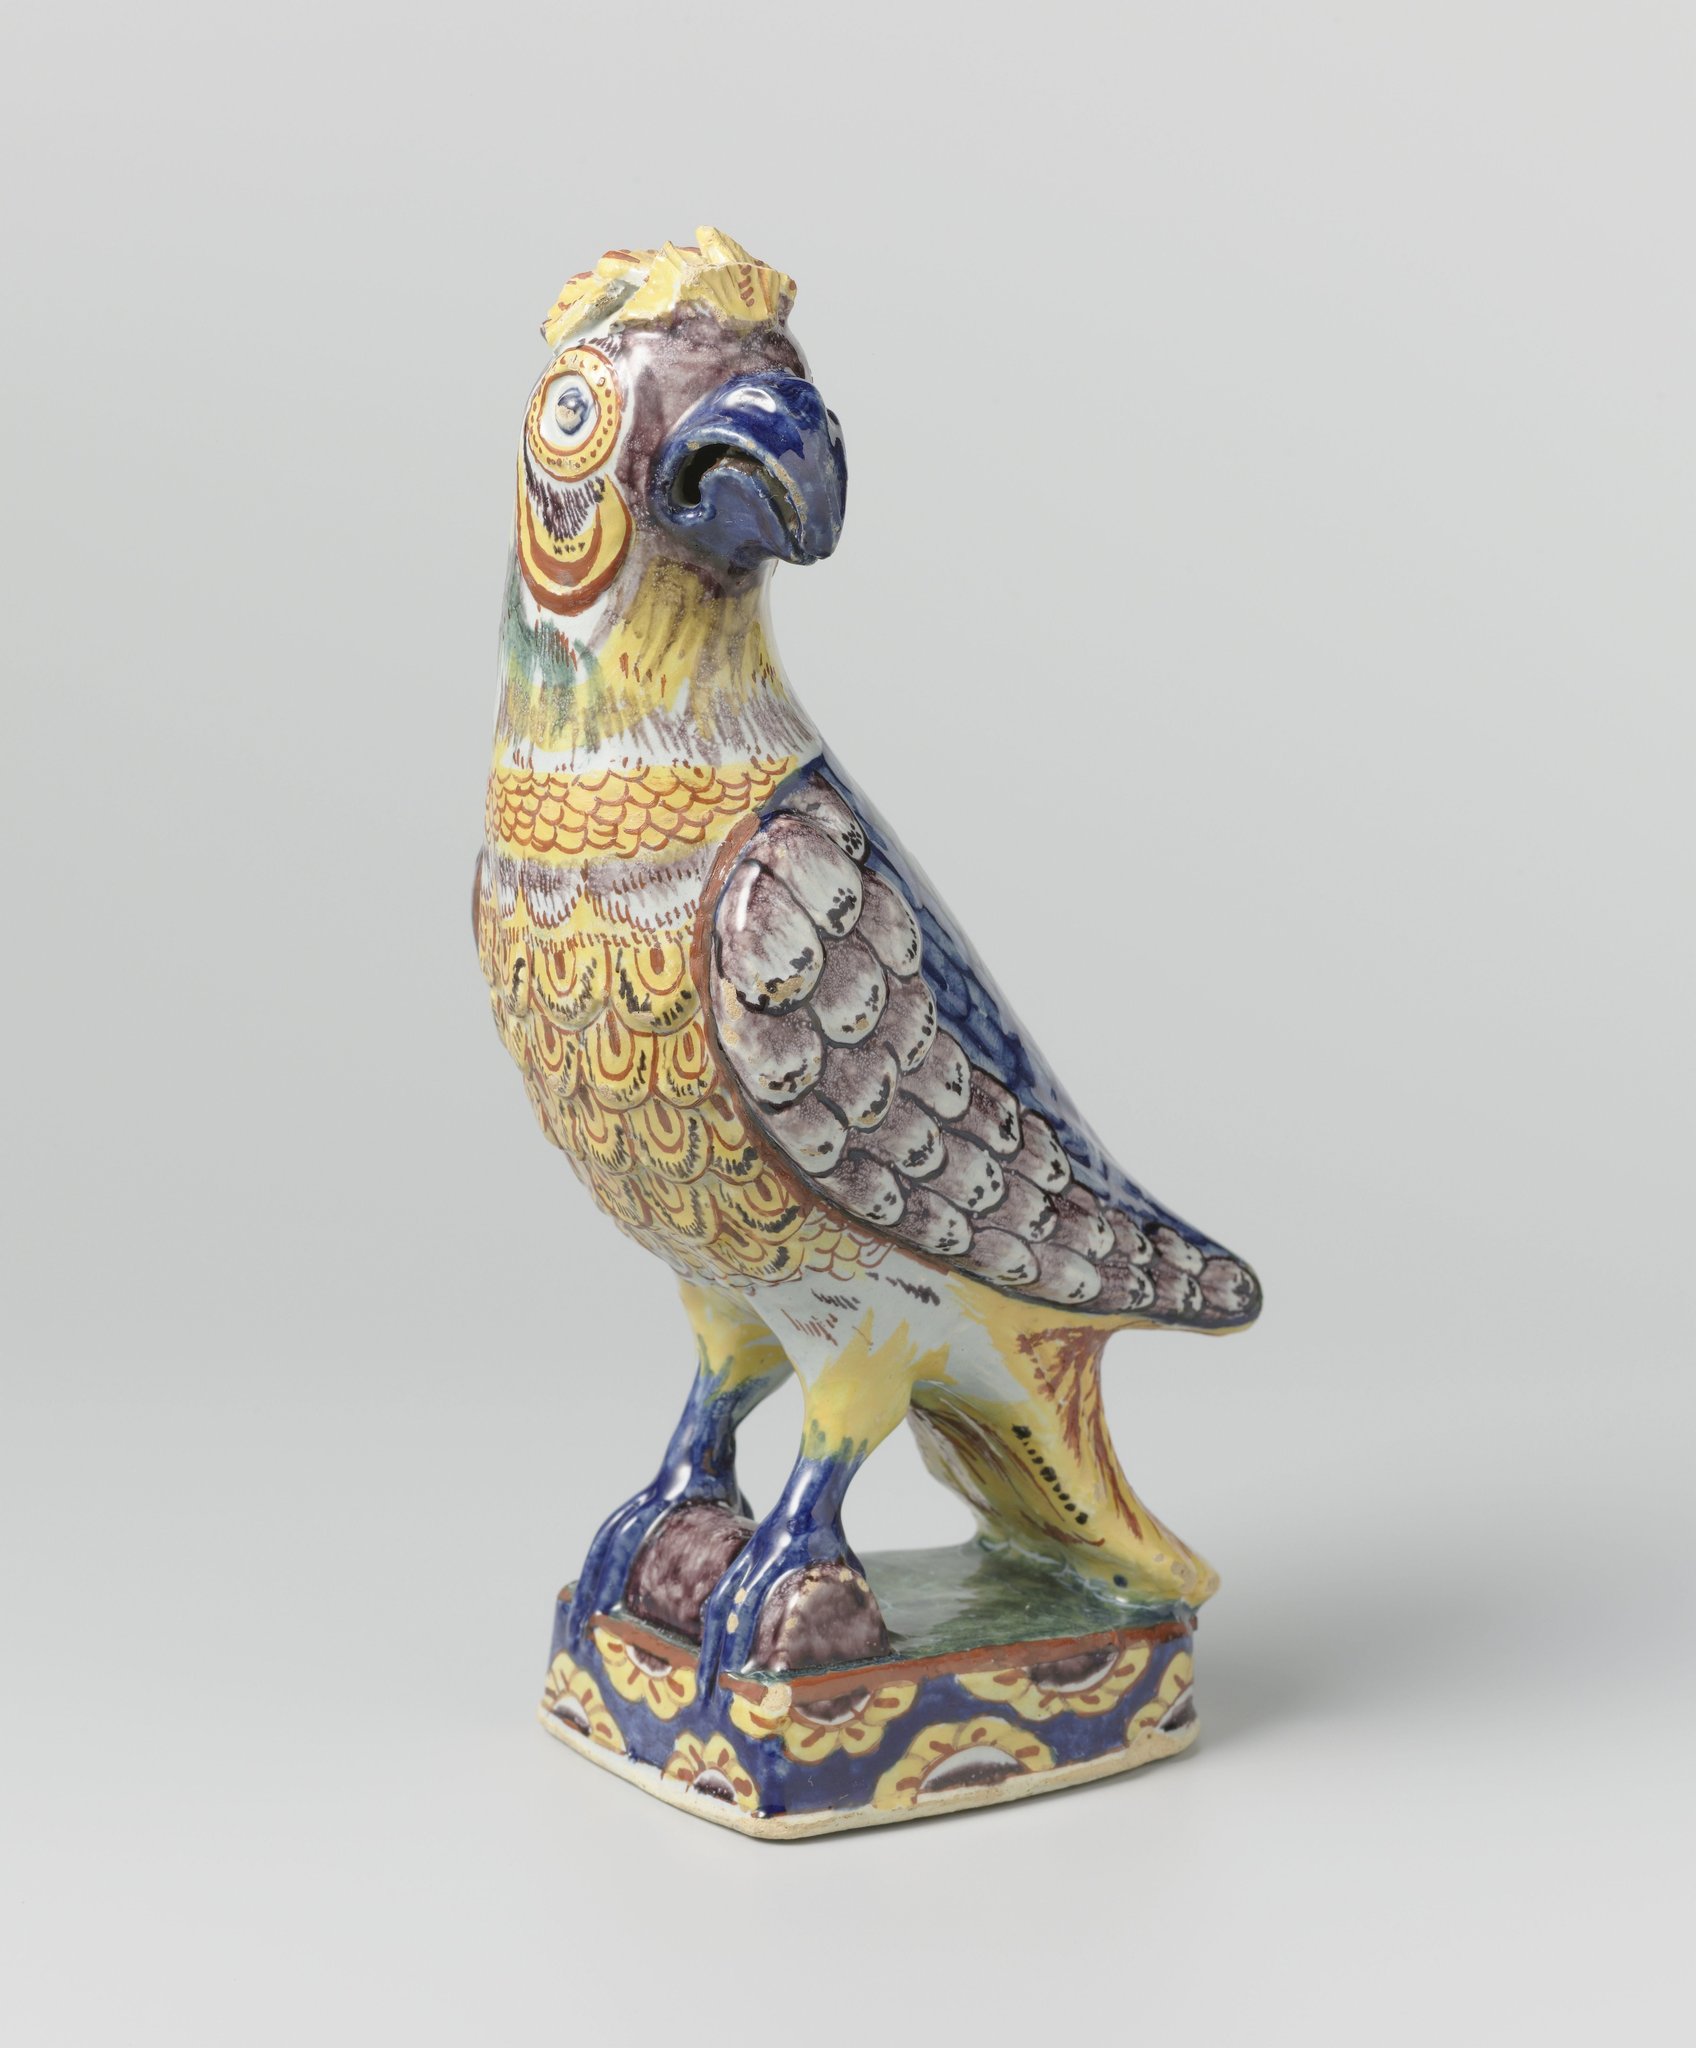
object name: figure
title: Papegaai van veelkleurig beschilderde faïence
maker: Anonymous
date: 1784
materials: earthenware, glaze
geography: delft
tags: ornamental birds: parrot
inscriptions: date: ‘1784’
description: Papegaai van faïence, veelkleurig beschilderd.